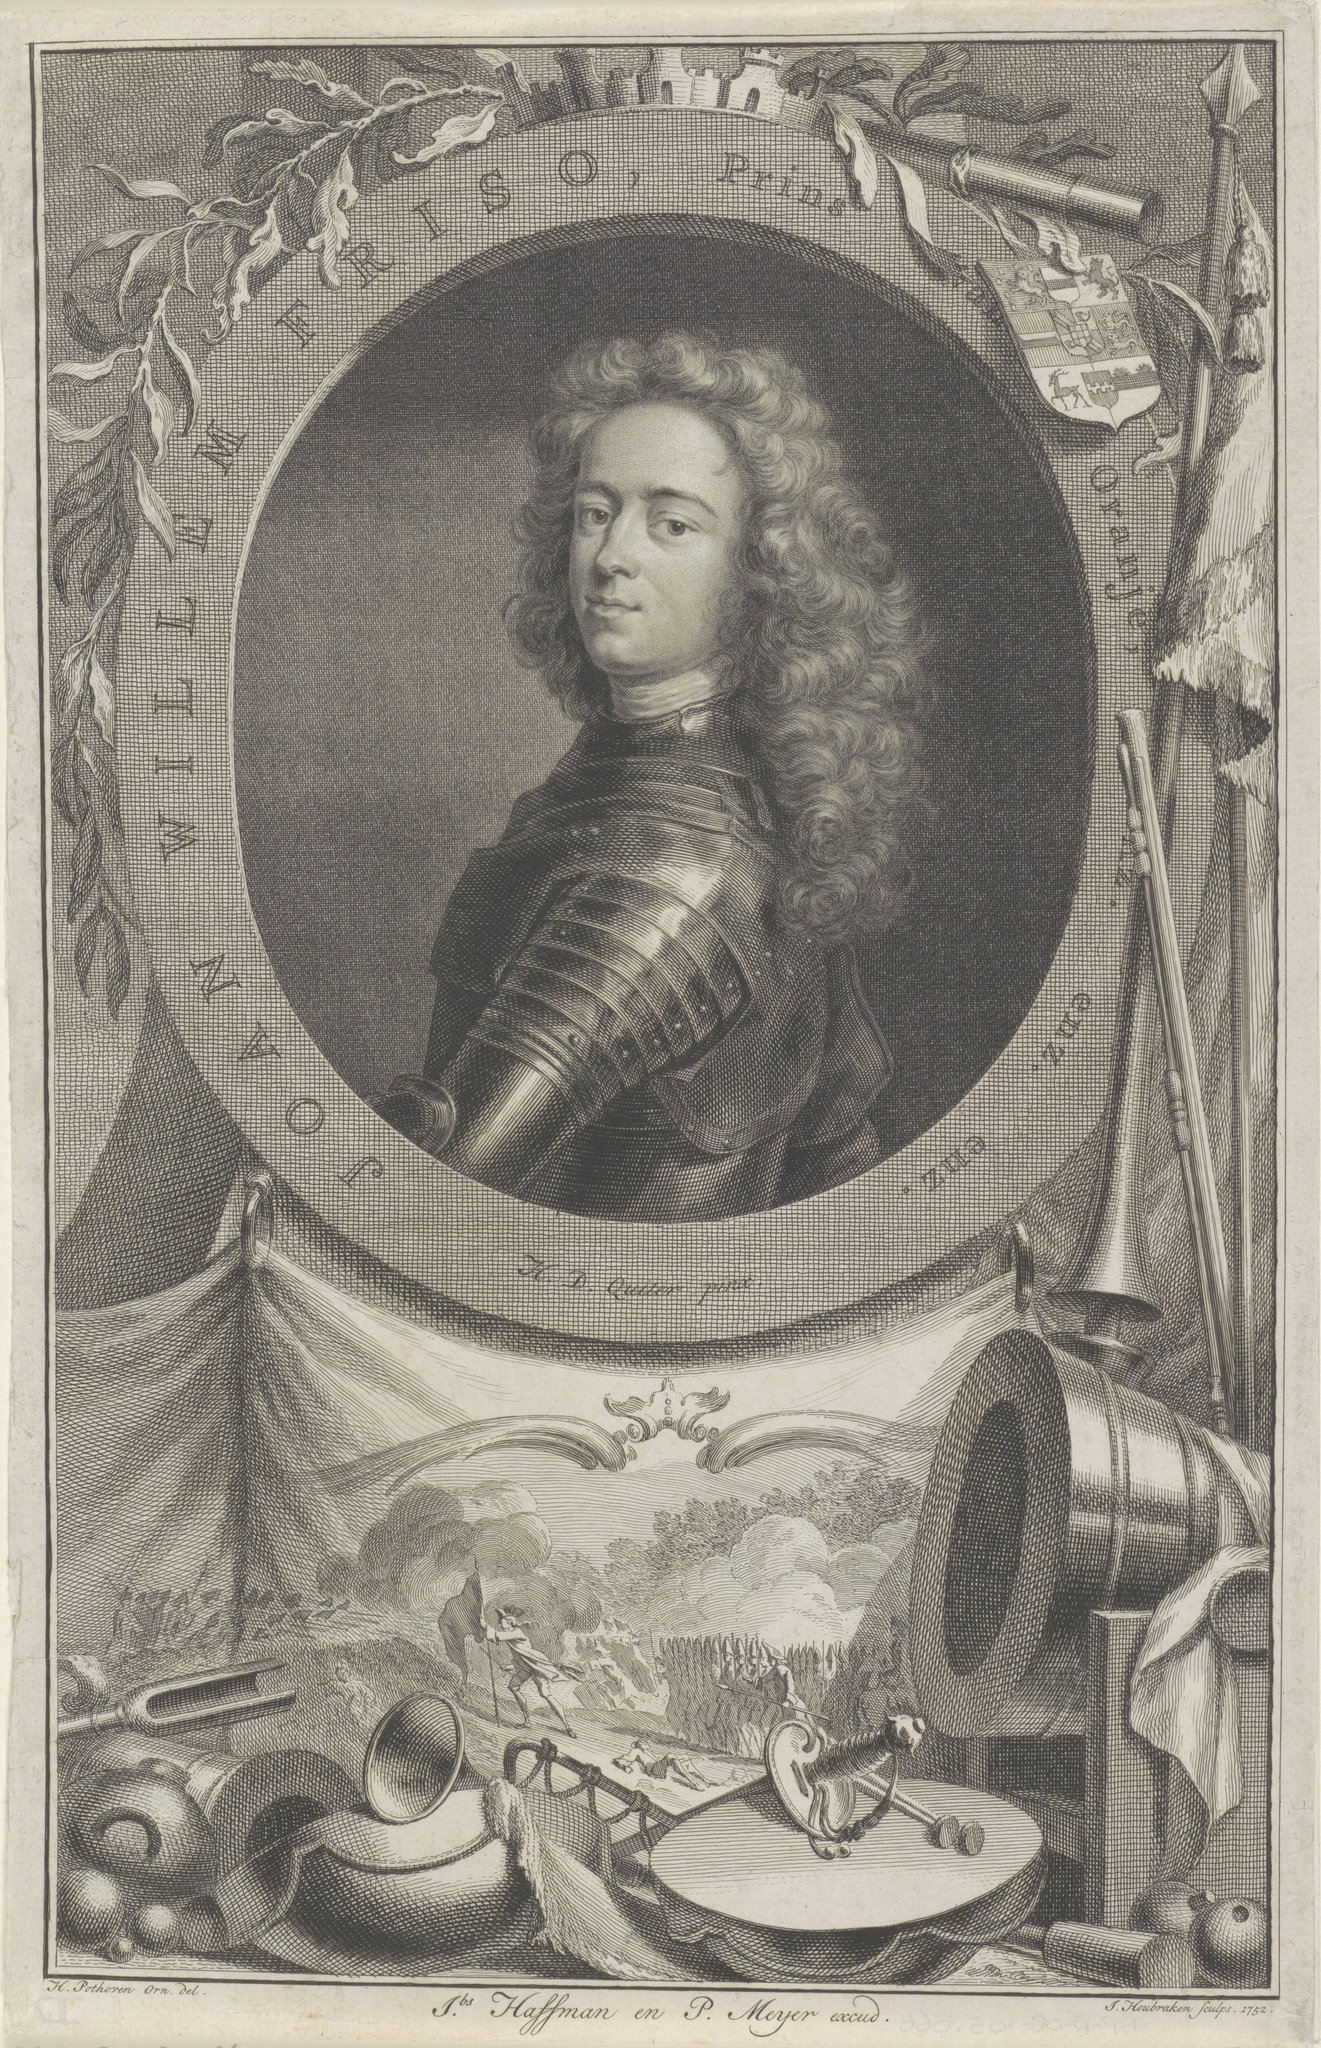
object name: print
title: Portret van Johan Willem Friso, prins van Oranje-Nassau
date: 1752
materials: paper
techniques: engraving, etching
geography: amsterdam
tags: johan willem friso (prins van oranje-nassau)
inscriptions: date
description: Portret van Johan Willem Friso in een ovaal met randschrift. Rondom ligt een aantal allegorische objecten, waaronder een lans, een kanon, een trommel en zijn wapen. Op het reliëf een voorstelling van een veldslag.